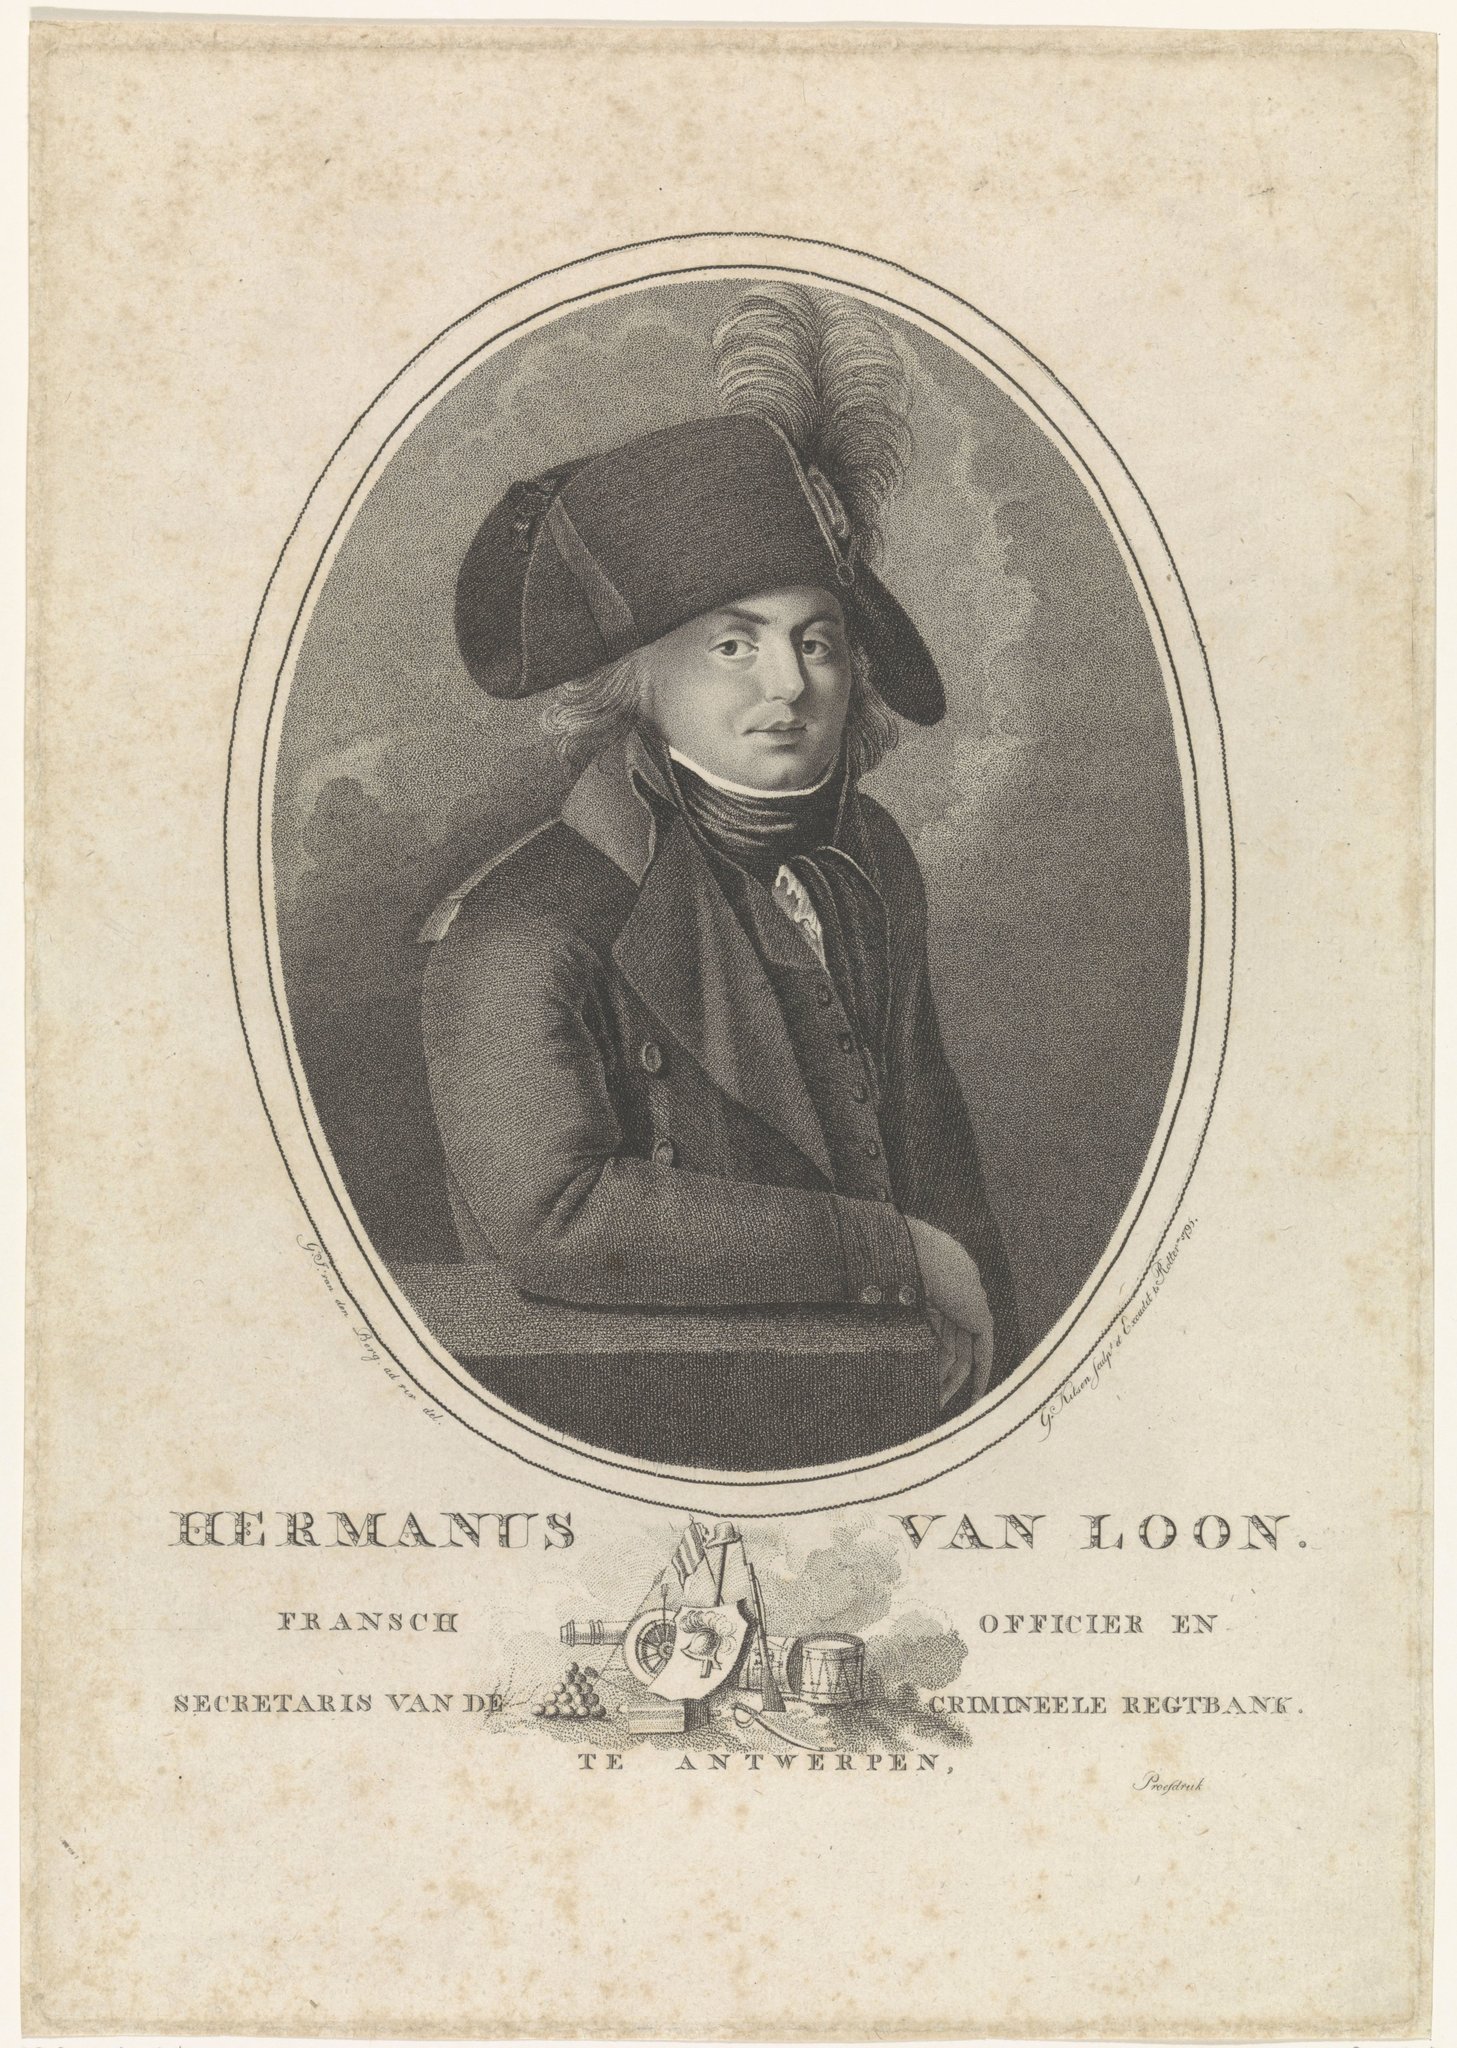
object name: print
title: Portret van Hermanus van Loon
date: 1795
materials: paper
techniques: engraving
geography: rotterdam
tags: print maker, harmanus van loon, weapons (+ artillery)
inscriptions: collector's mark: Lugt 2228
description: Portret van Hermanus van Loon, Franse officier en secretaris van de criminele rechtbank te Antwerpen. Hij draagt een steek op het hoofd en steunt met zijn rechterarm op een halfhoge muur. Onder het portret de titel en een vignet met een kanon en trommels.